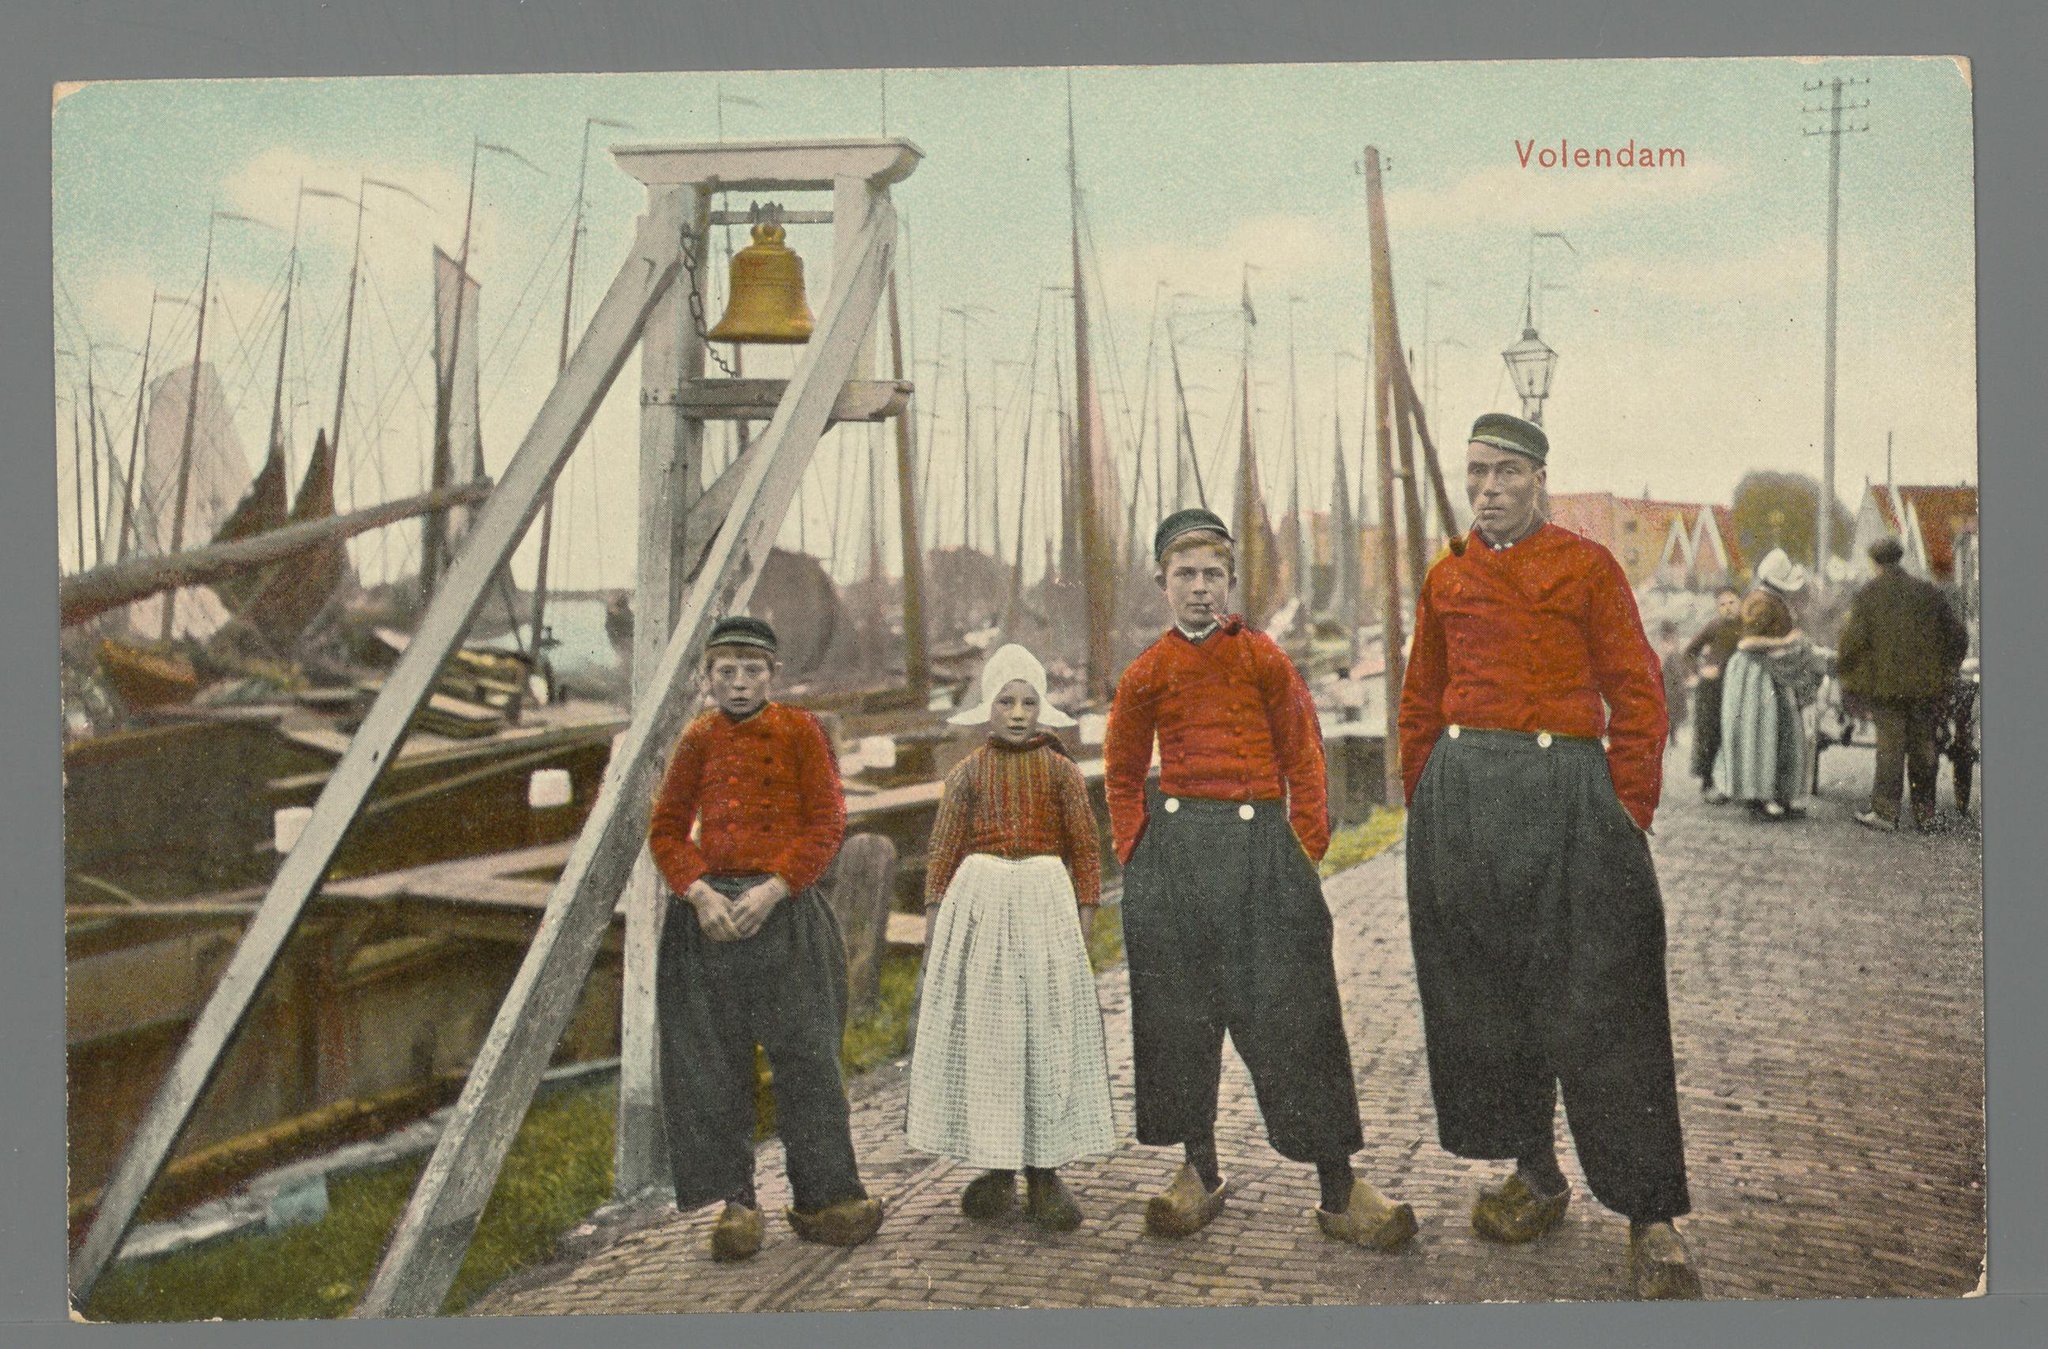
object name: photomechanical print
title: Volendam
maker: Anonymous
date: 1908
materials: cardboard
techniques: lithograph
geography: volendam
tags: clothes, costume, fisherman, anonymous historical persons portrayed in a group, in a group-portrait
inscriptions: date